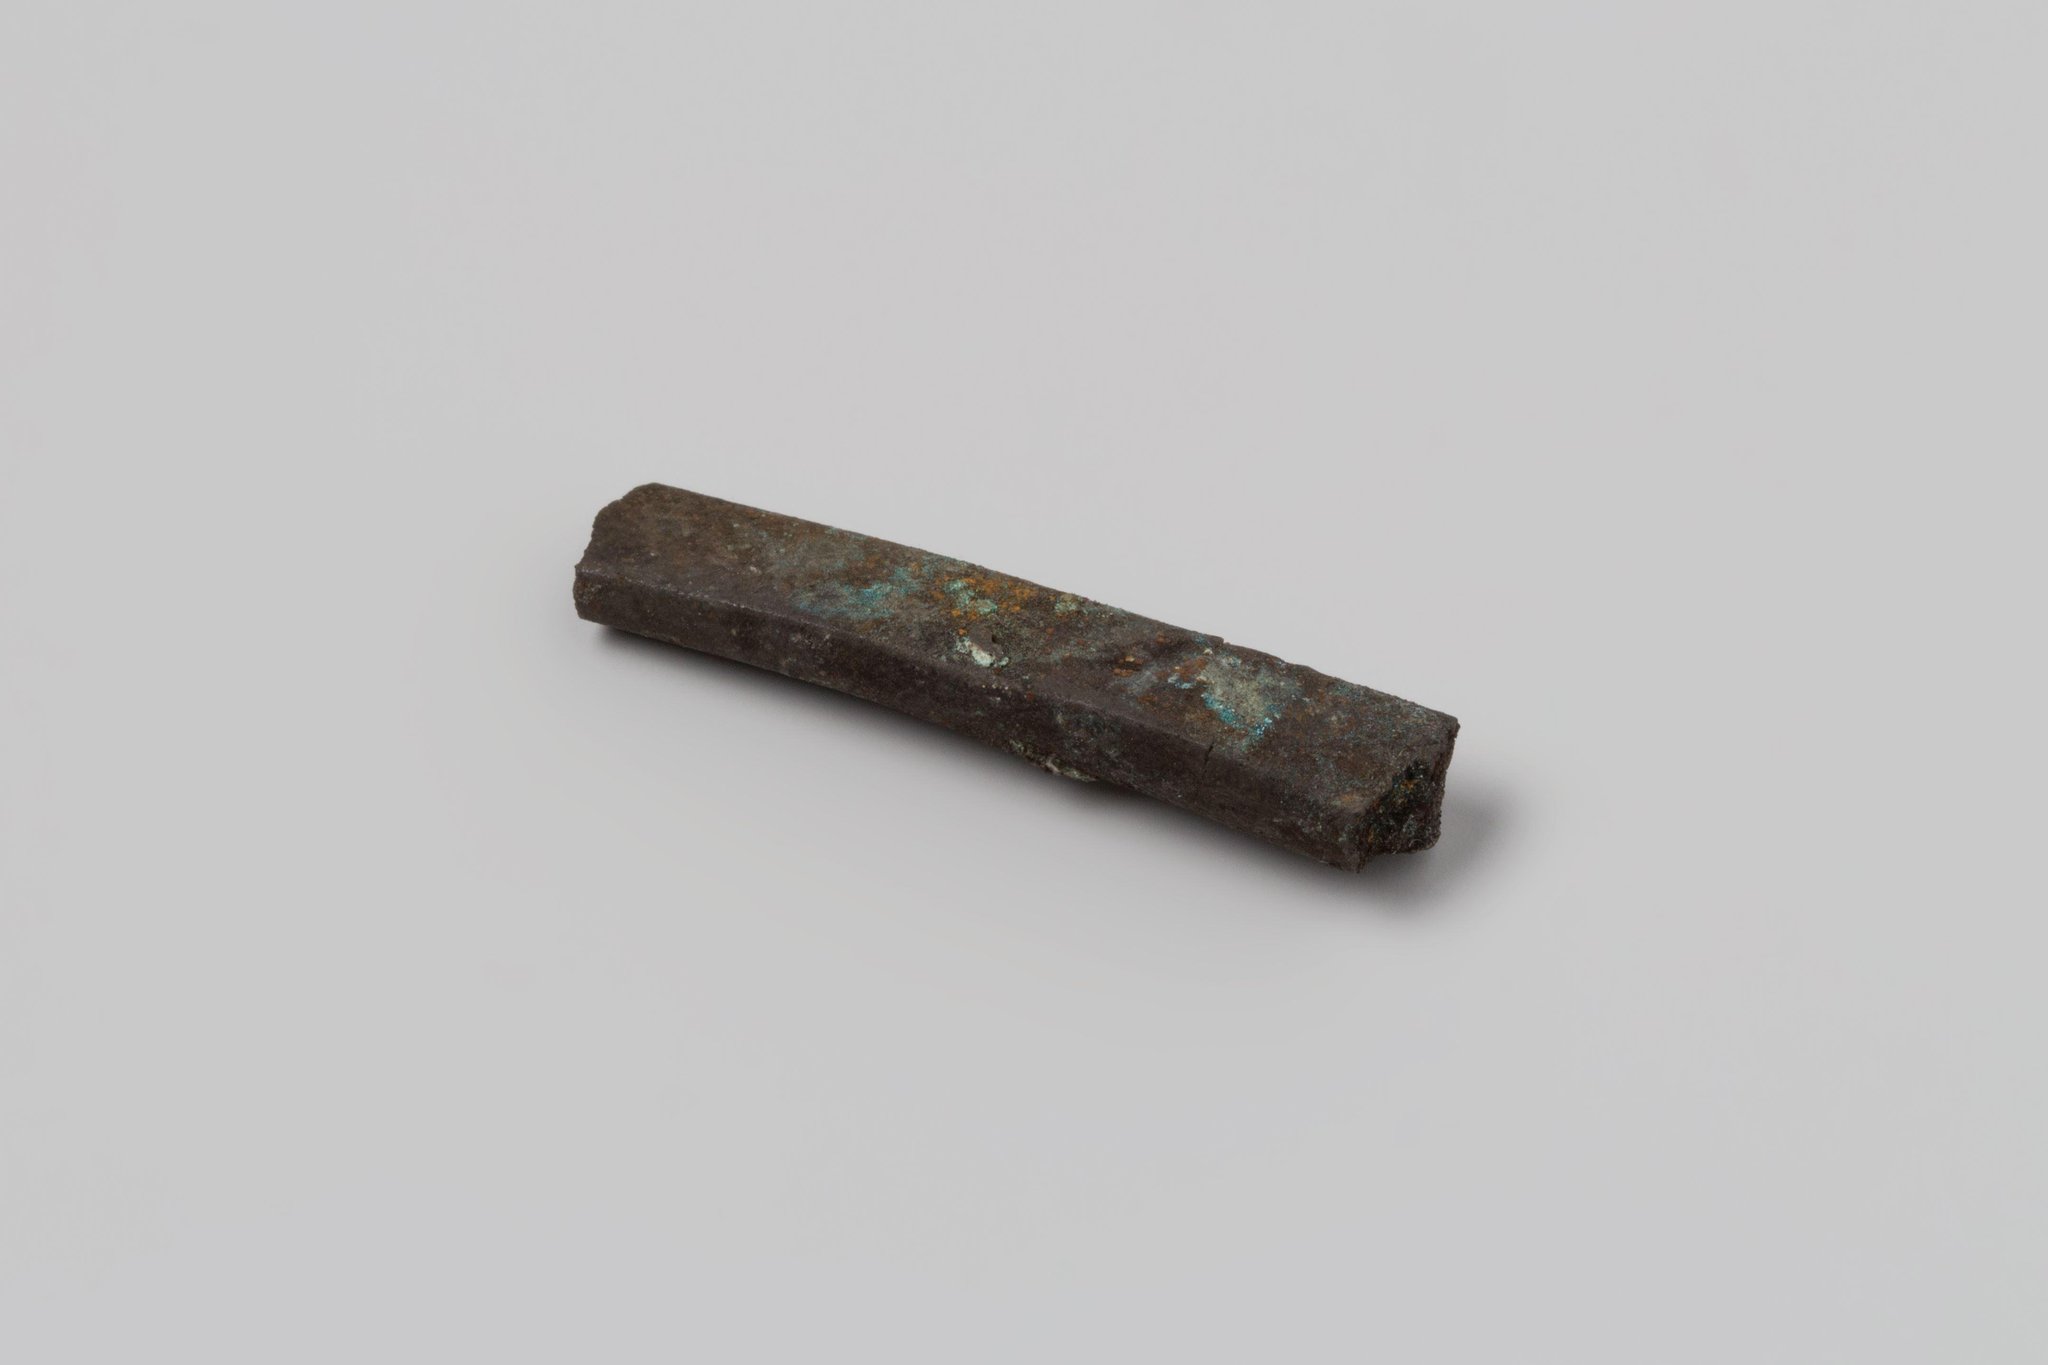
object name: spoon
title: Fragment steel van vork of lepel uit het wrak van de Oost-Indiëvaarder Hollandia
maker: Anonymous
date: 1700-1743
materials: copper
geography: netherlands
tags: verenigde oostindische compagnie, hollandia (schip), annet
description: Cutlery, fragment: stem of fork or spoon; fragm, sim. NG 1980-27H536a.